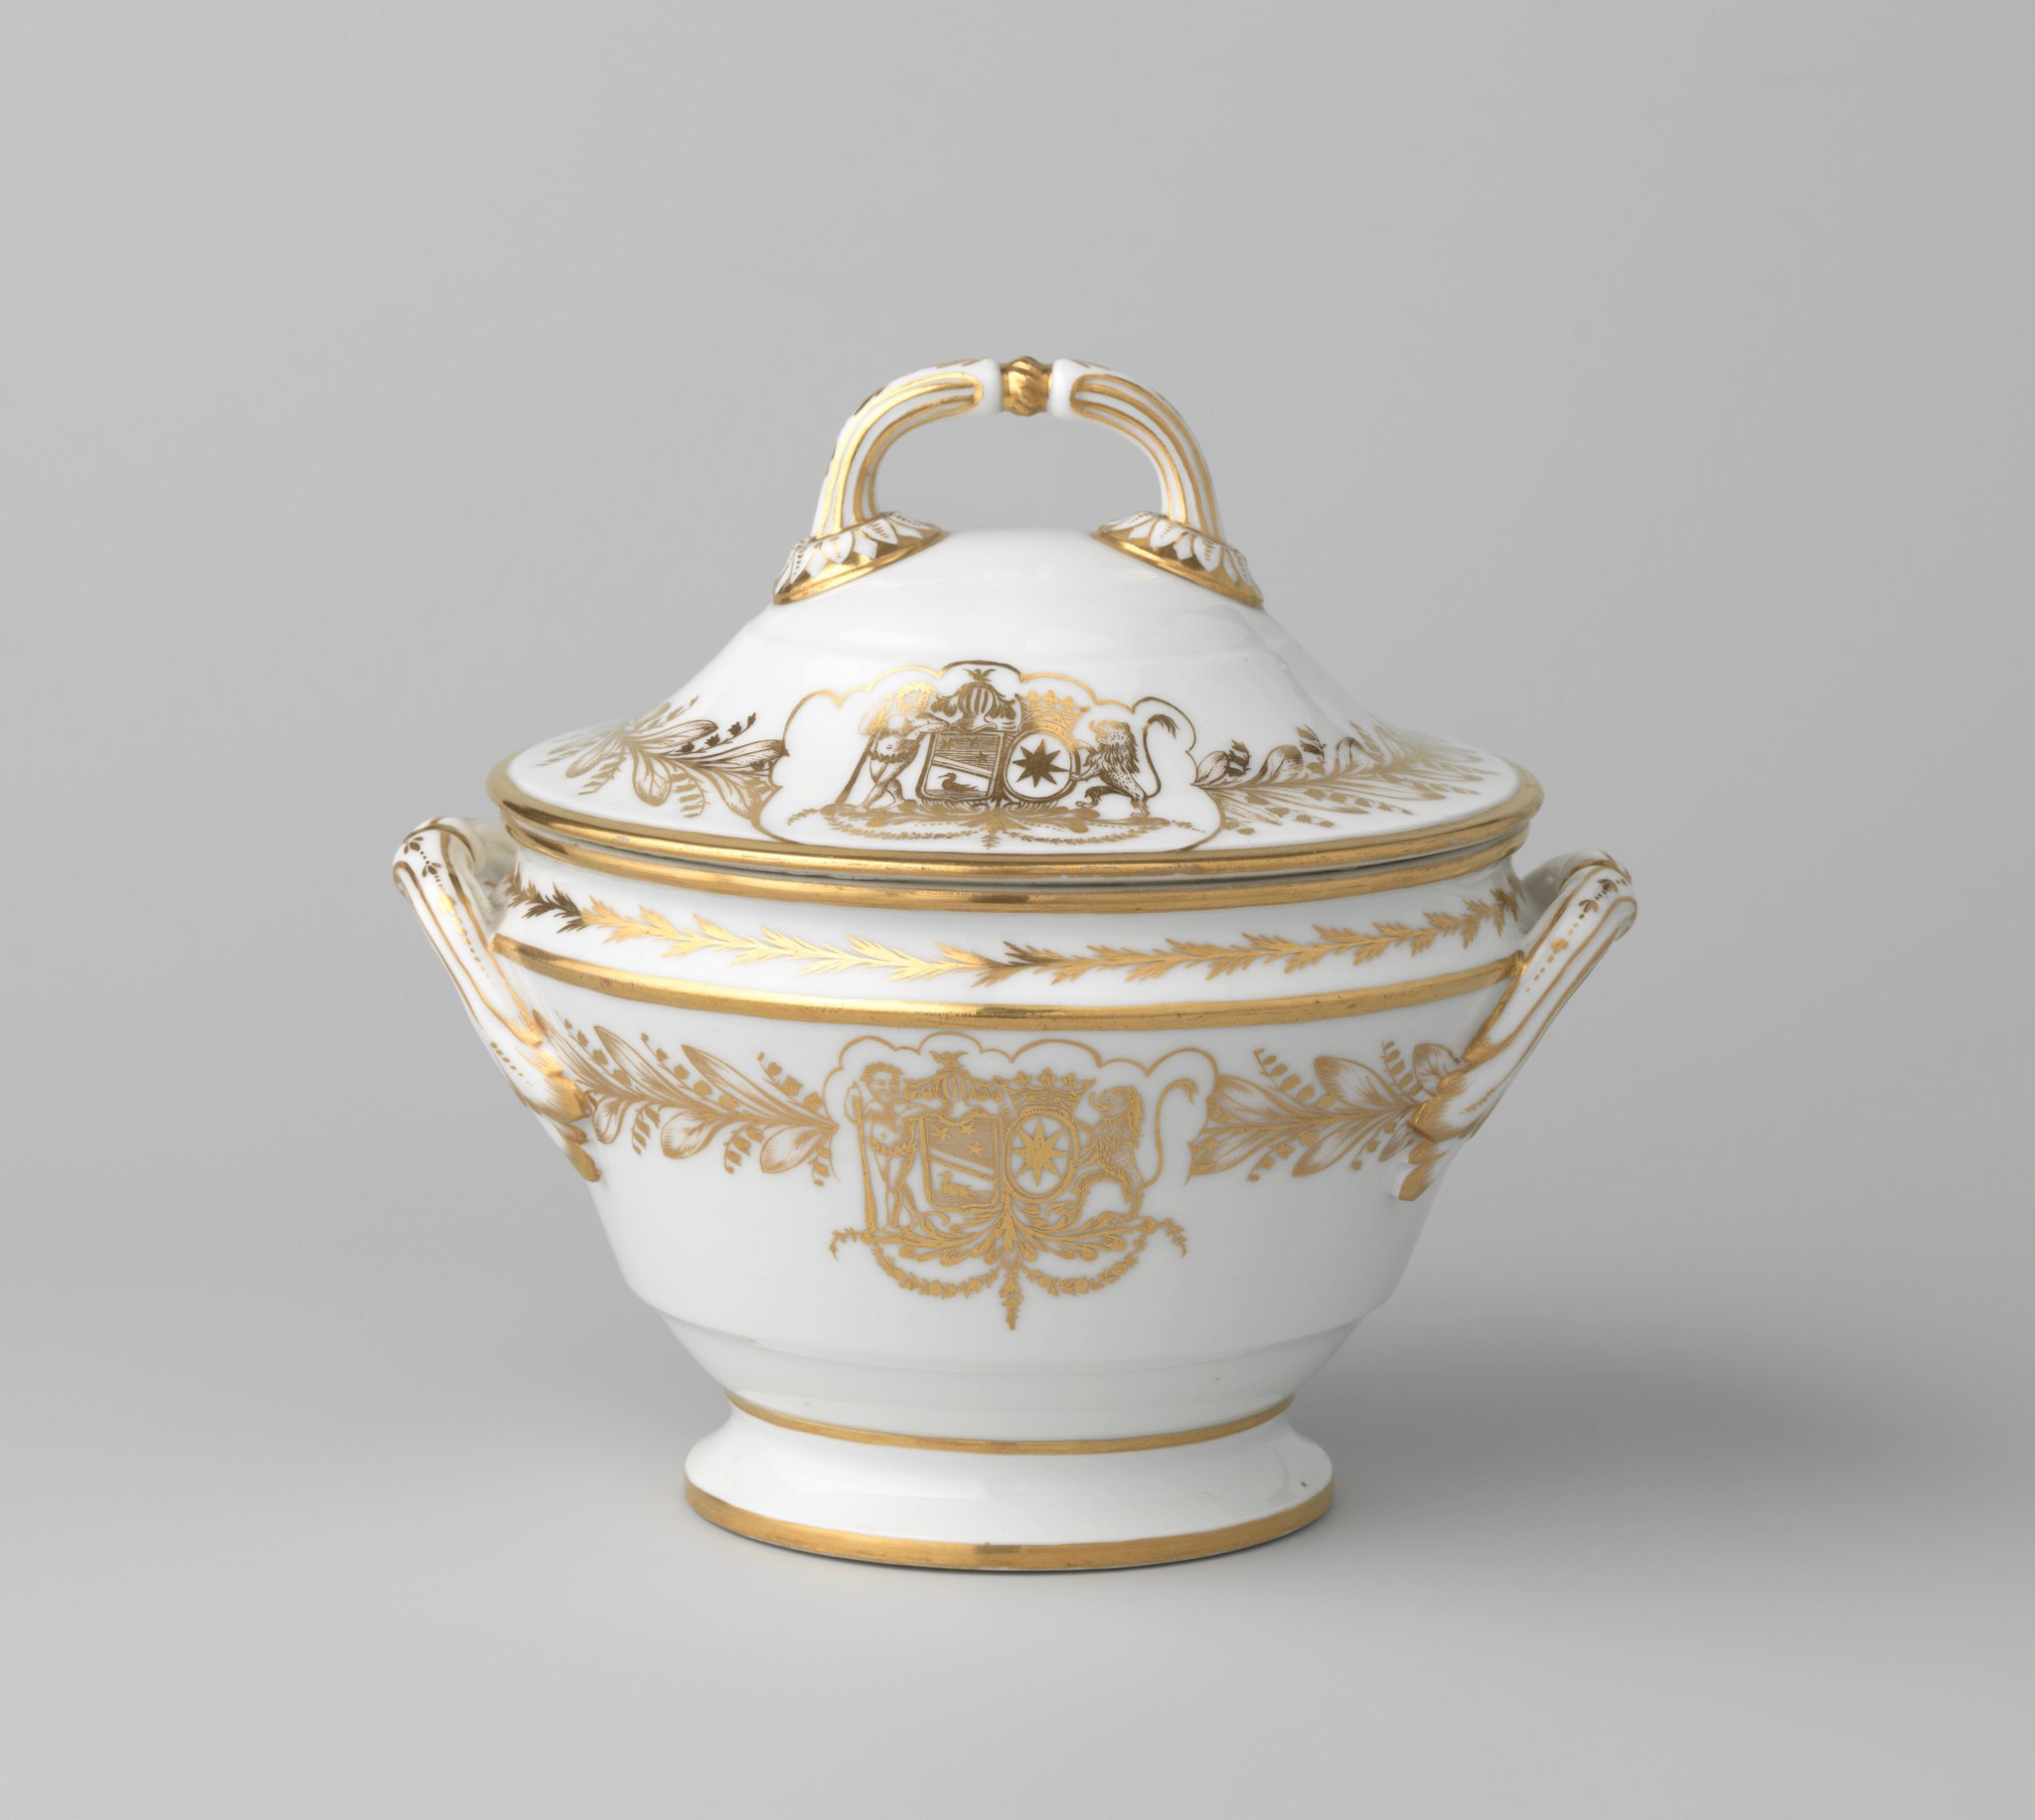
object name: service set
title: Tureen with the coat of arms of Hendrik Peter Godfried Quack and Isabella Gertraud von Carnap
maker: Anonymous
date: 1790-1800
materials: glaze, gold, paint, porcelain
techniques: firing, forming, gilding, turning, vitrification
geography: low countries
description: Terrine van porselein op hoge voet en met twee handvatten, beschilderd op het glazuur met goud. Op de buitenwand het alliantiewapen van Hendrik Peter Godfried Quack en Isabella Gertraud von Carnap en een bloemrank. De schouder met een bladrank. Gouden banden op de voet en rand. De handvatten zijn in de vorm van gemodelleerde en met goud aangezette bladranken.